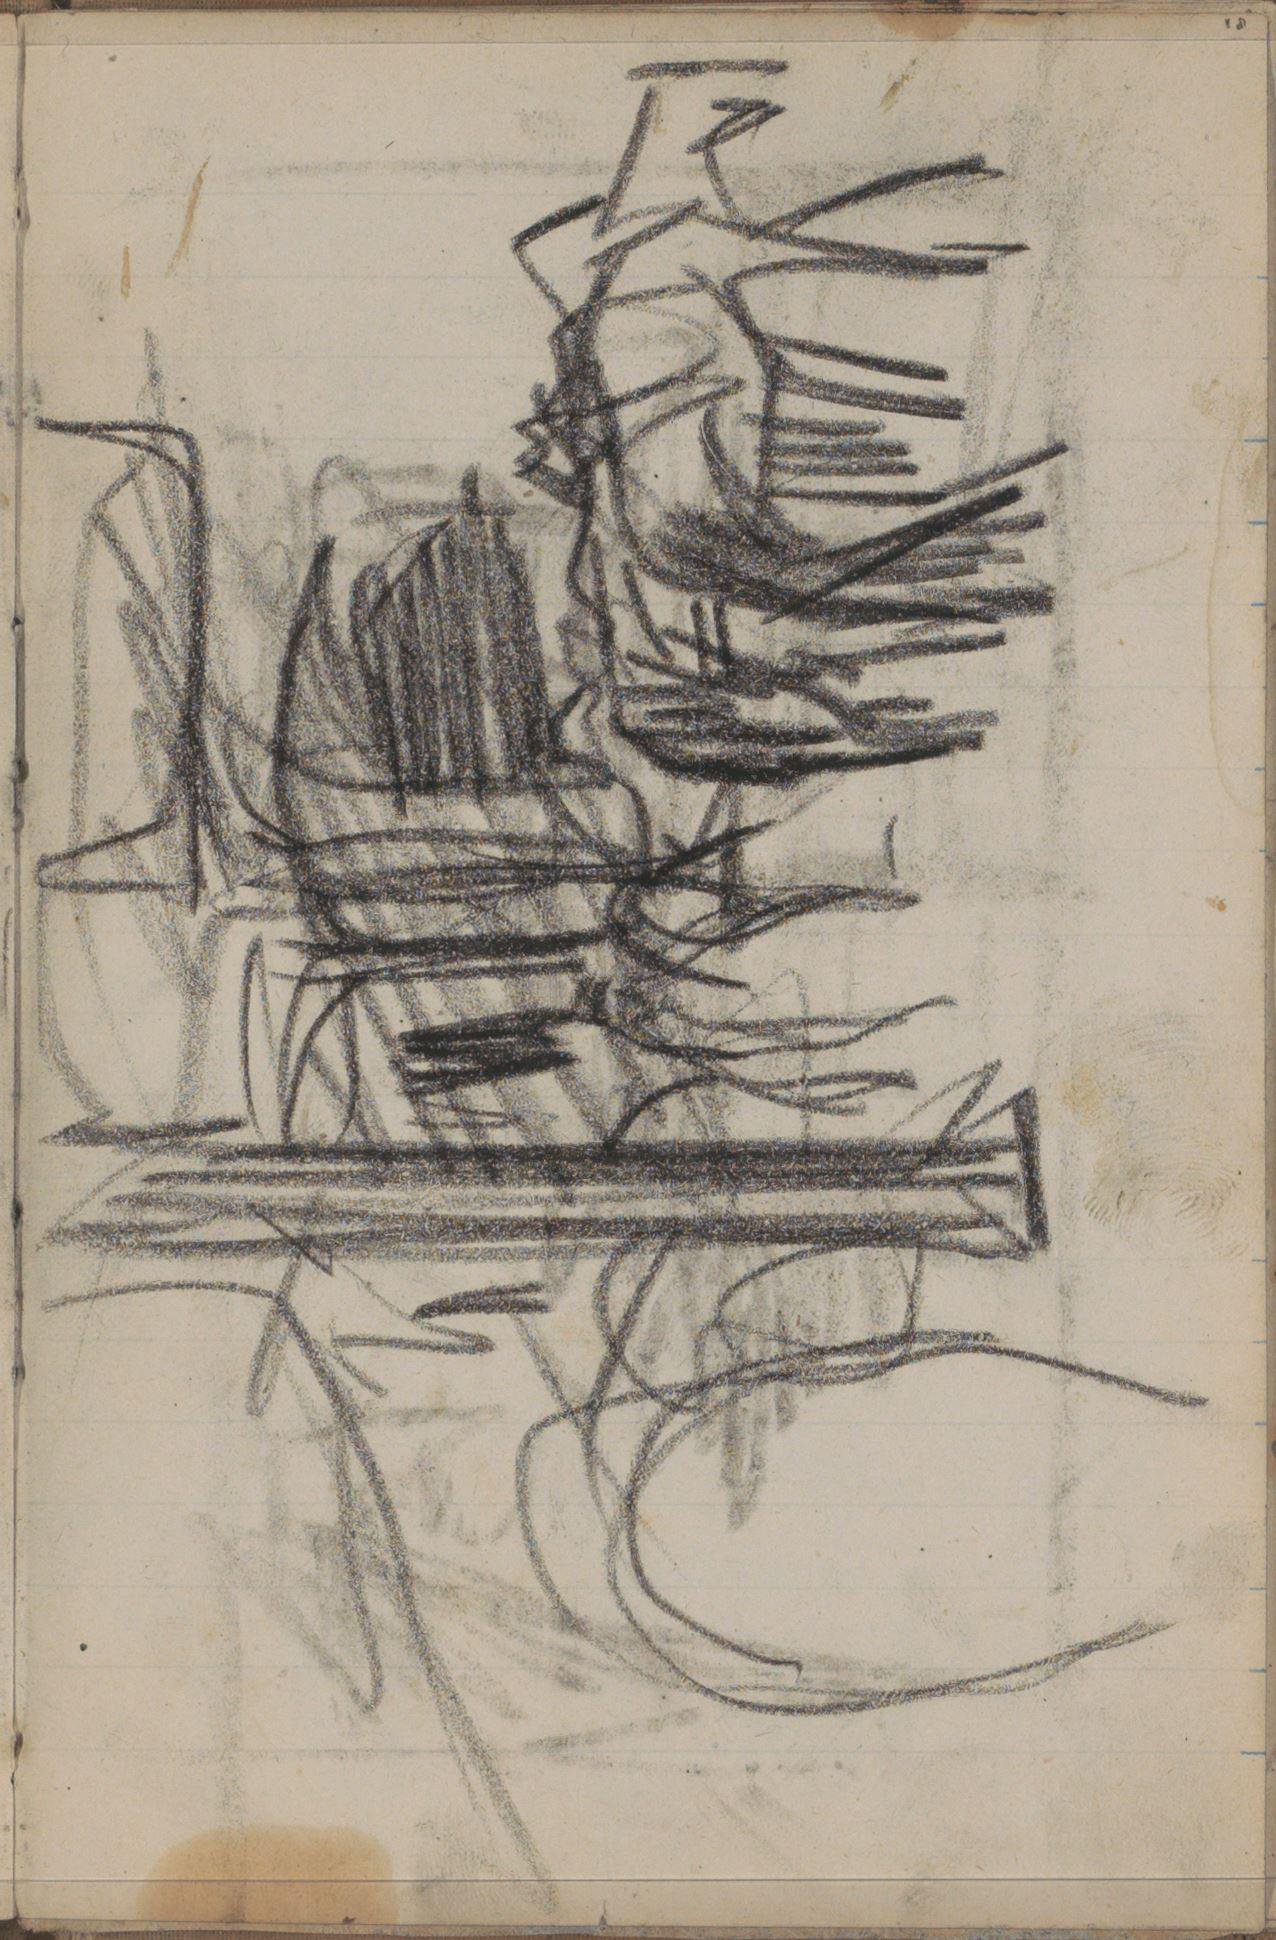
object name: sketchbook leaf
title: Paarden bij een zuil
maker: marius bauer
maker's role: draughtsman, print maker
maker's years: 1867-1932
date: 1888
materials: chalk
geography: istanbul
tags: column, pillar ~ architecture, horse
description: Pagina 18 uit een schetsboek met 58 bladen.